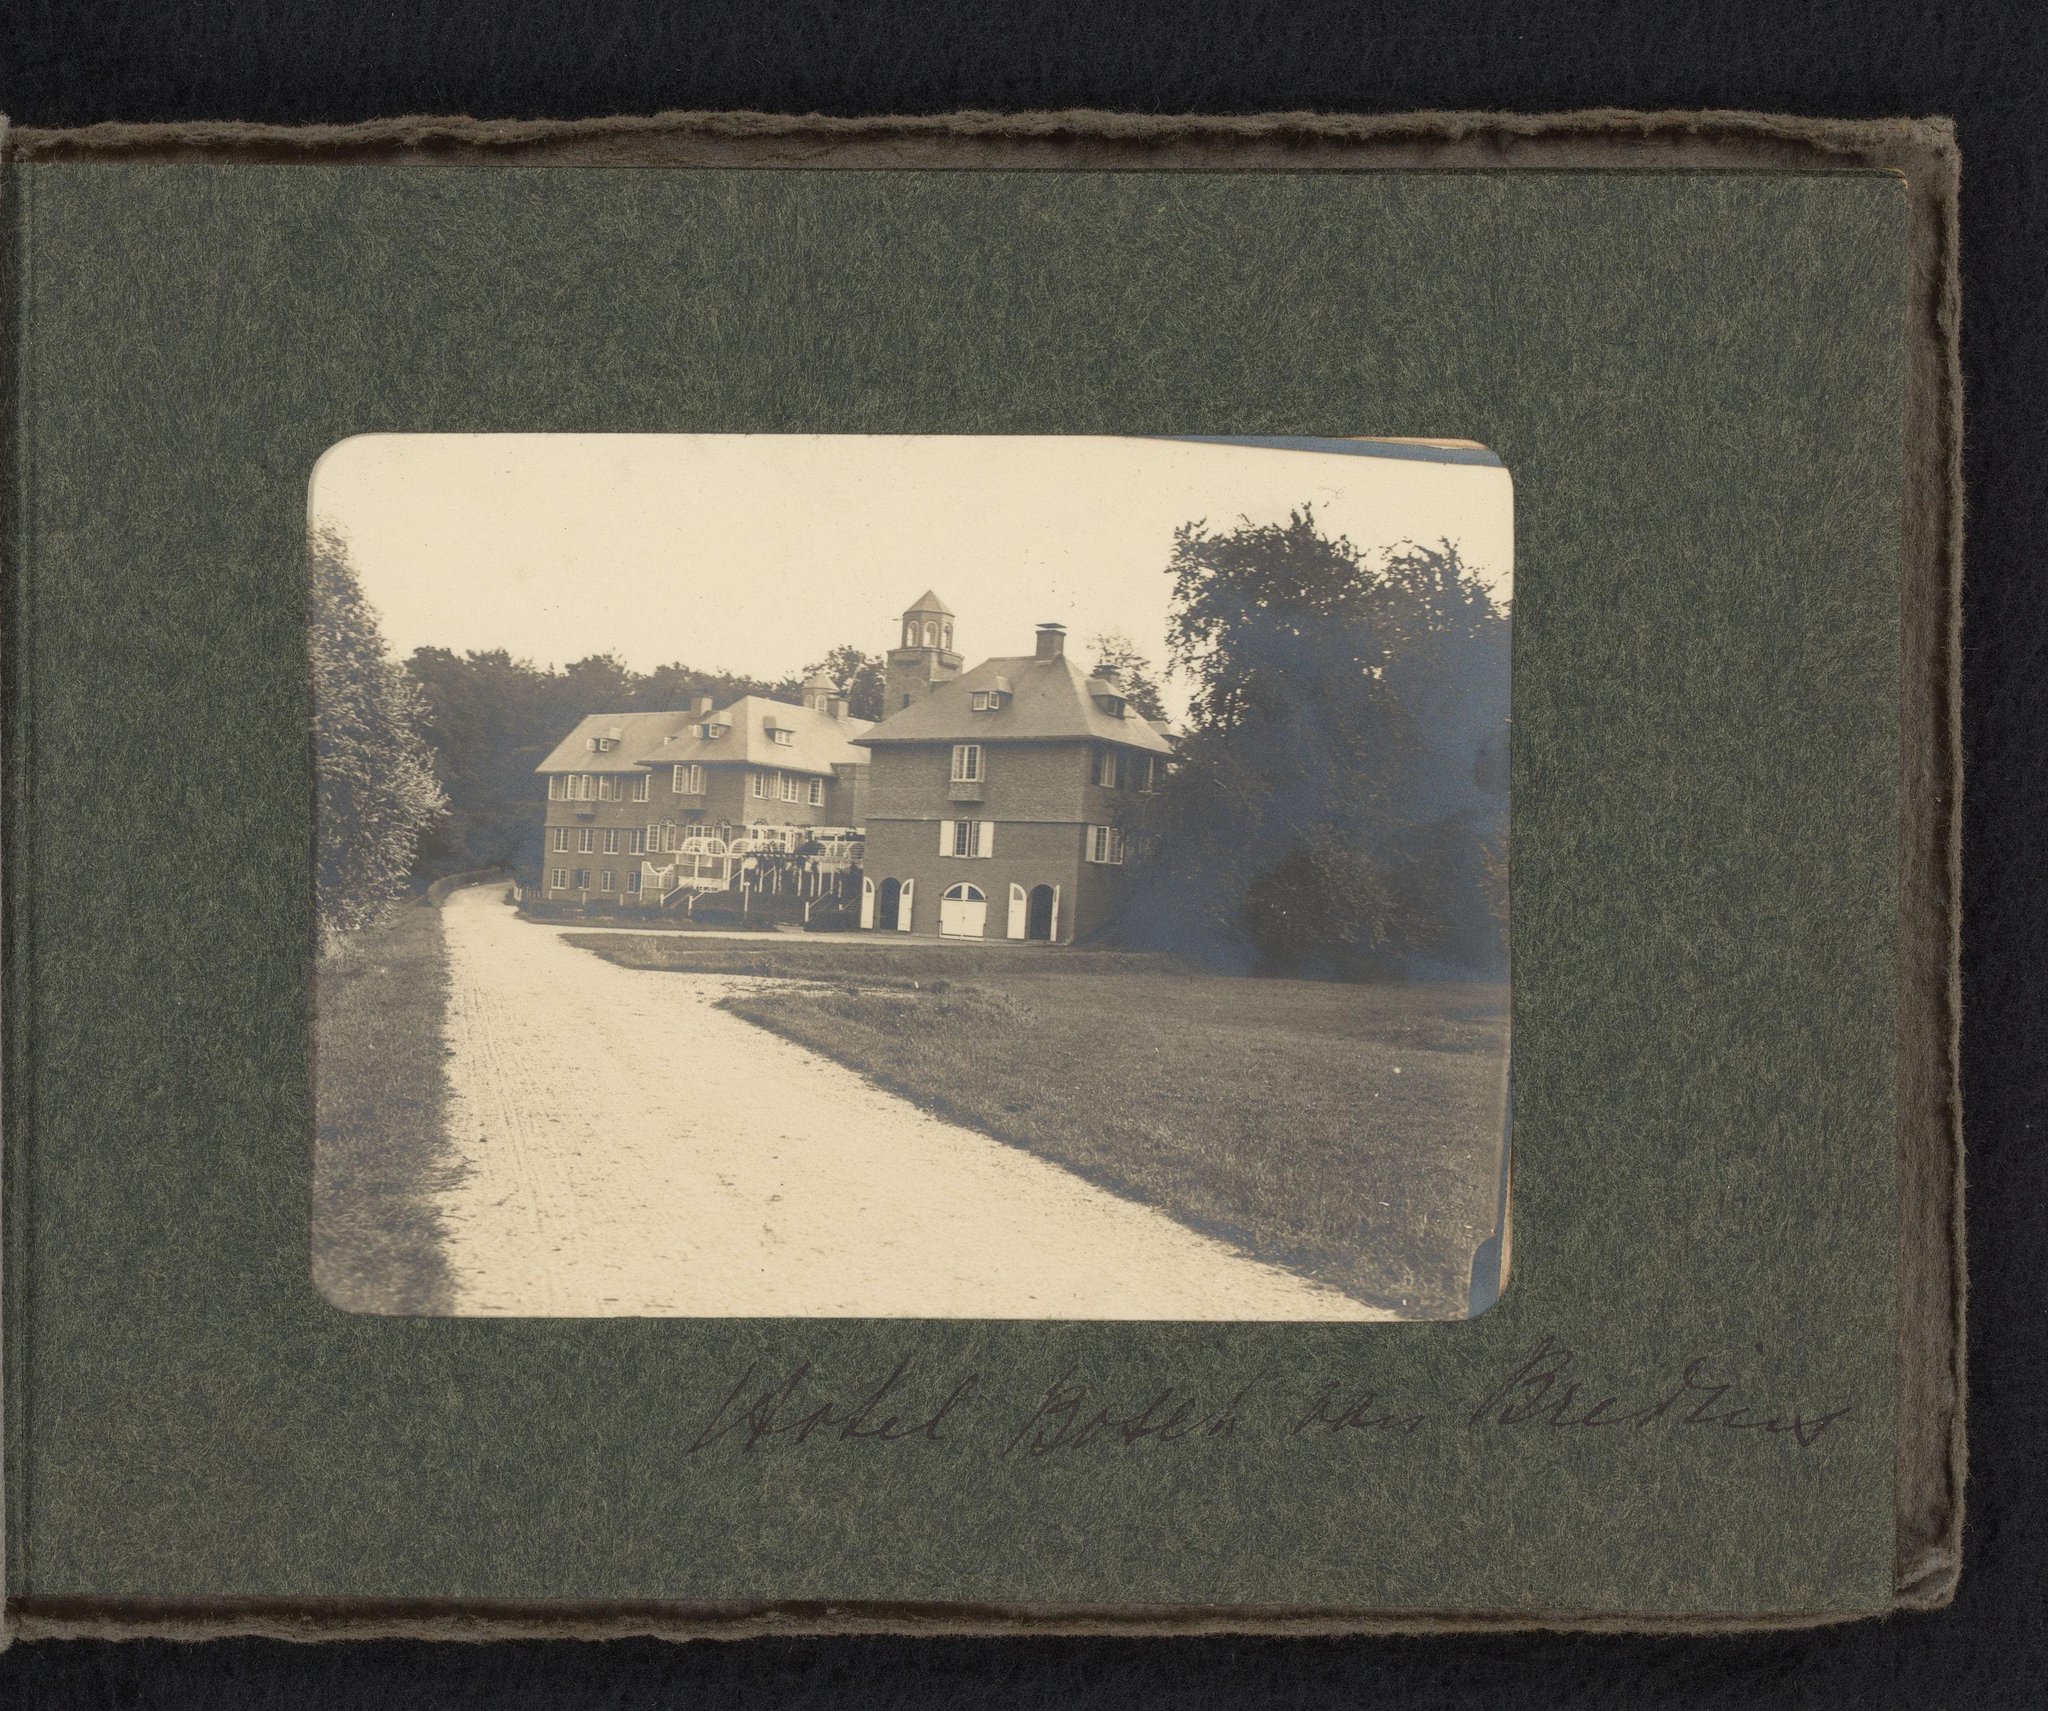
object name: photograph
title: Gezicht op hotel Bosch van Bredius bij Laren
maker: hendrik herman van den berg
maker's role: amateurfotograaf, jurist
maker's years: 1875-1944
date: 1912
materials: paper, cardboard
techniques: gelatin silver print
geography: laren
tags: exterior ~ representation of a building, hotel, hostelry, inn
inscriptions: caption: ‘Hotel Bosch van Bredius’